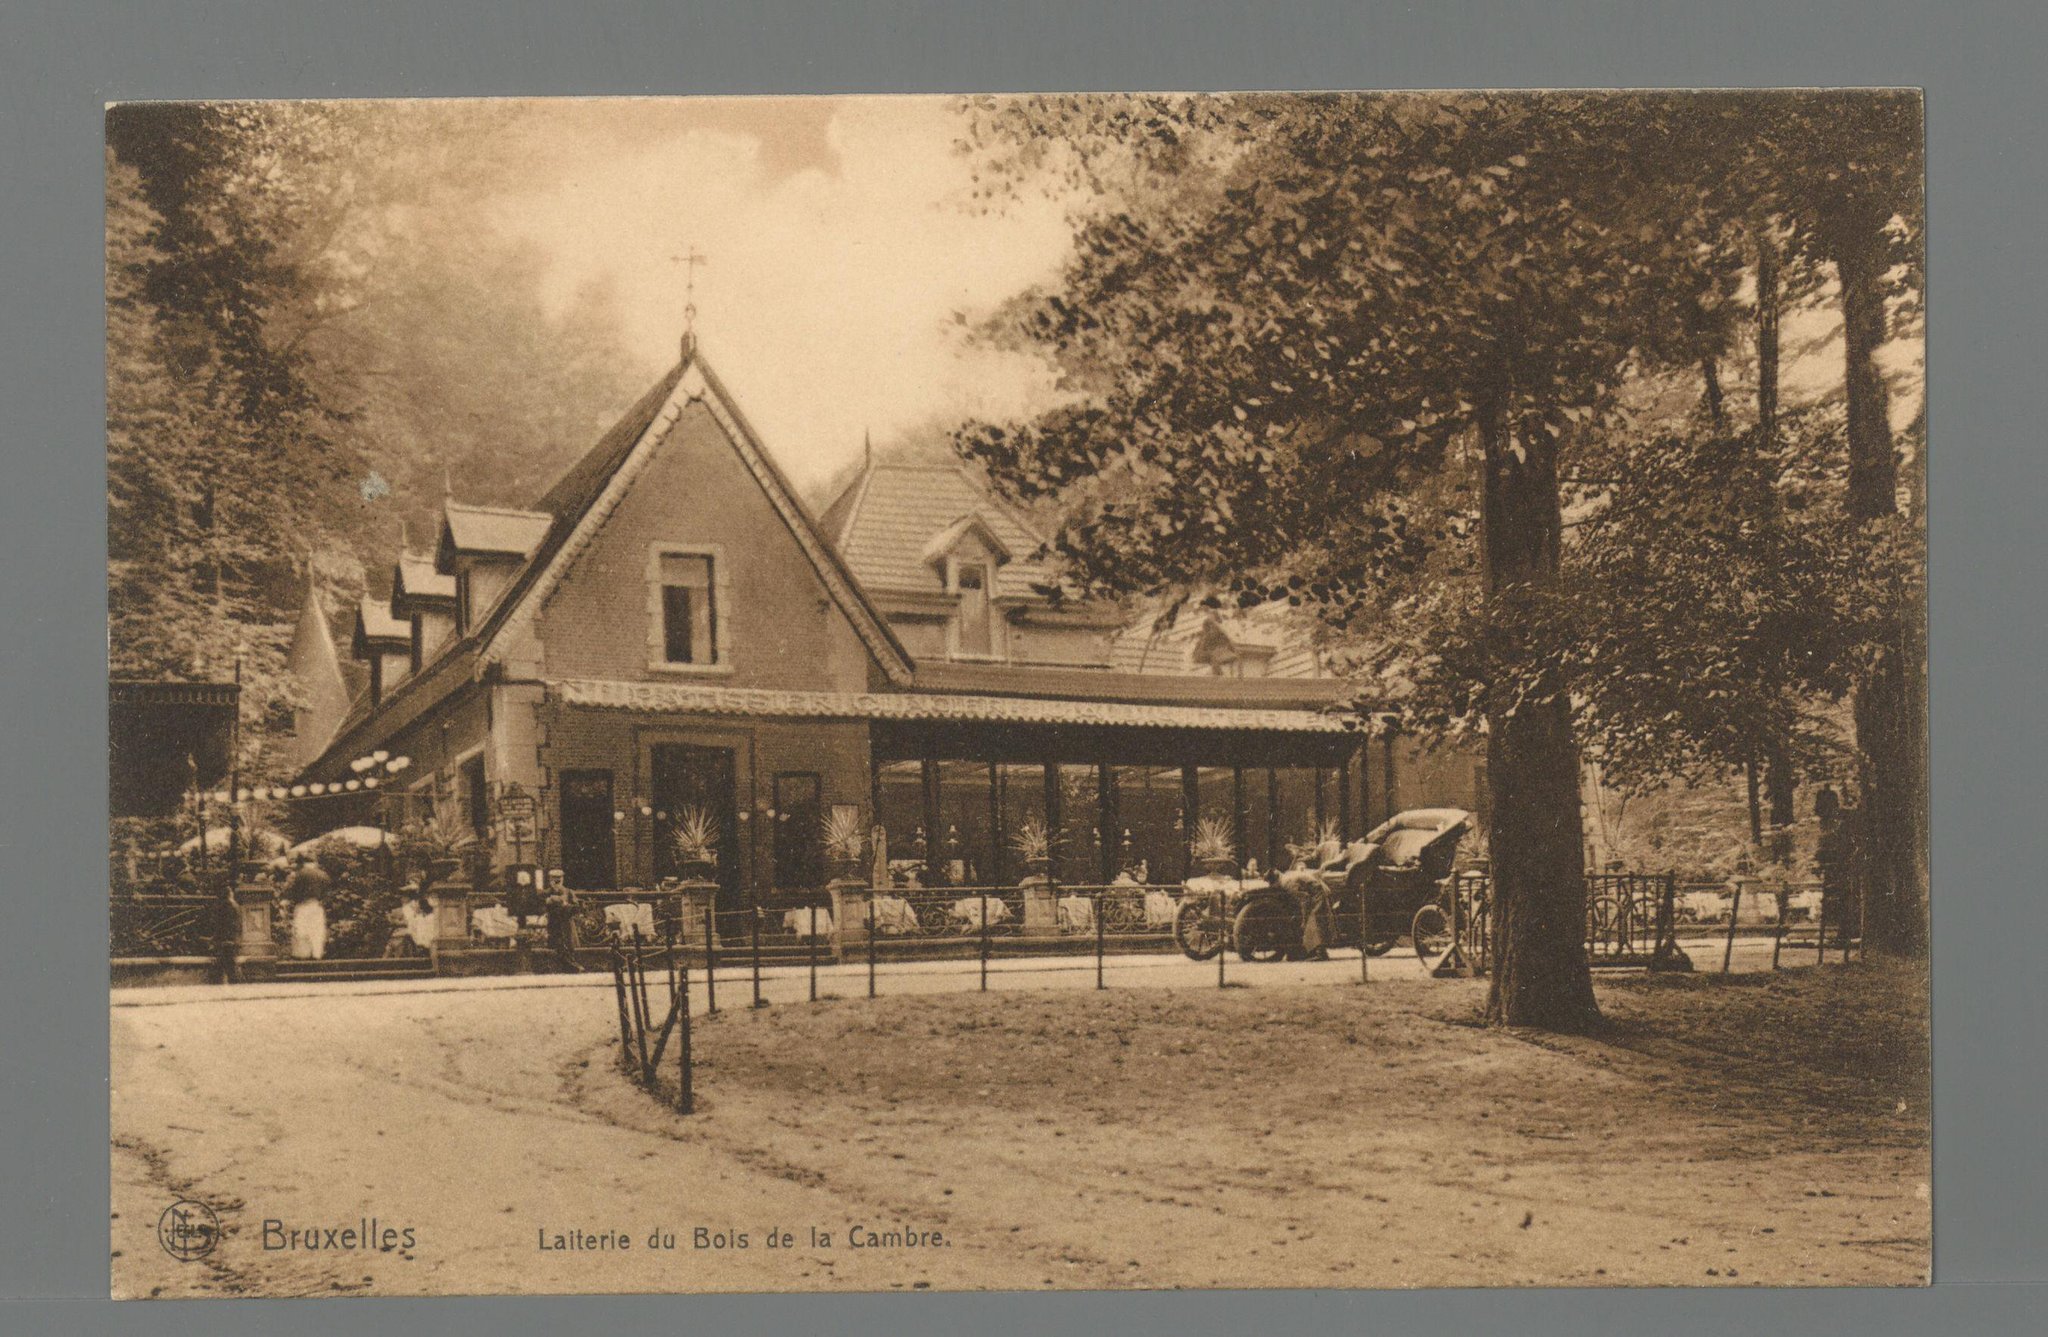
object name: ansichtkaart, prentbriefkaart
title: Serie Bruxelles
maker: Anonymous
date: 1907-1930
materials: cardboard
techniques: photograph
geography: brussels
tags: traffic by road or path with motor-vehicle, tea garden, garden restaurant, public gardens, park